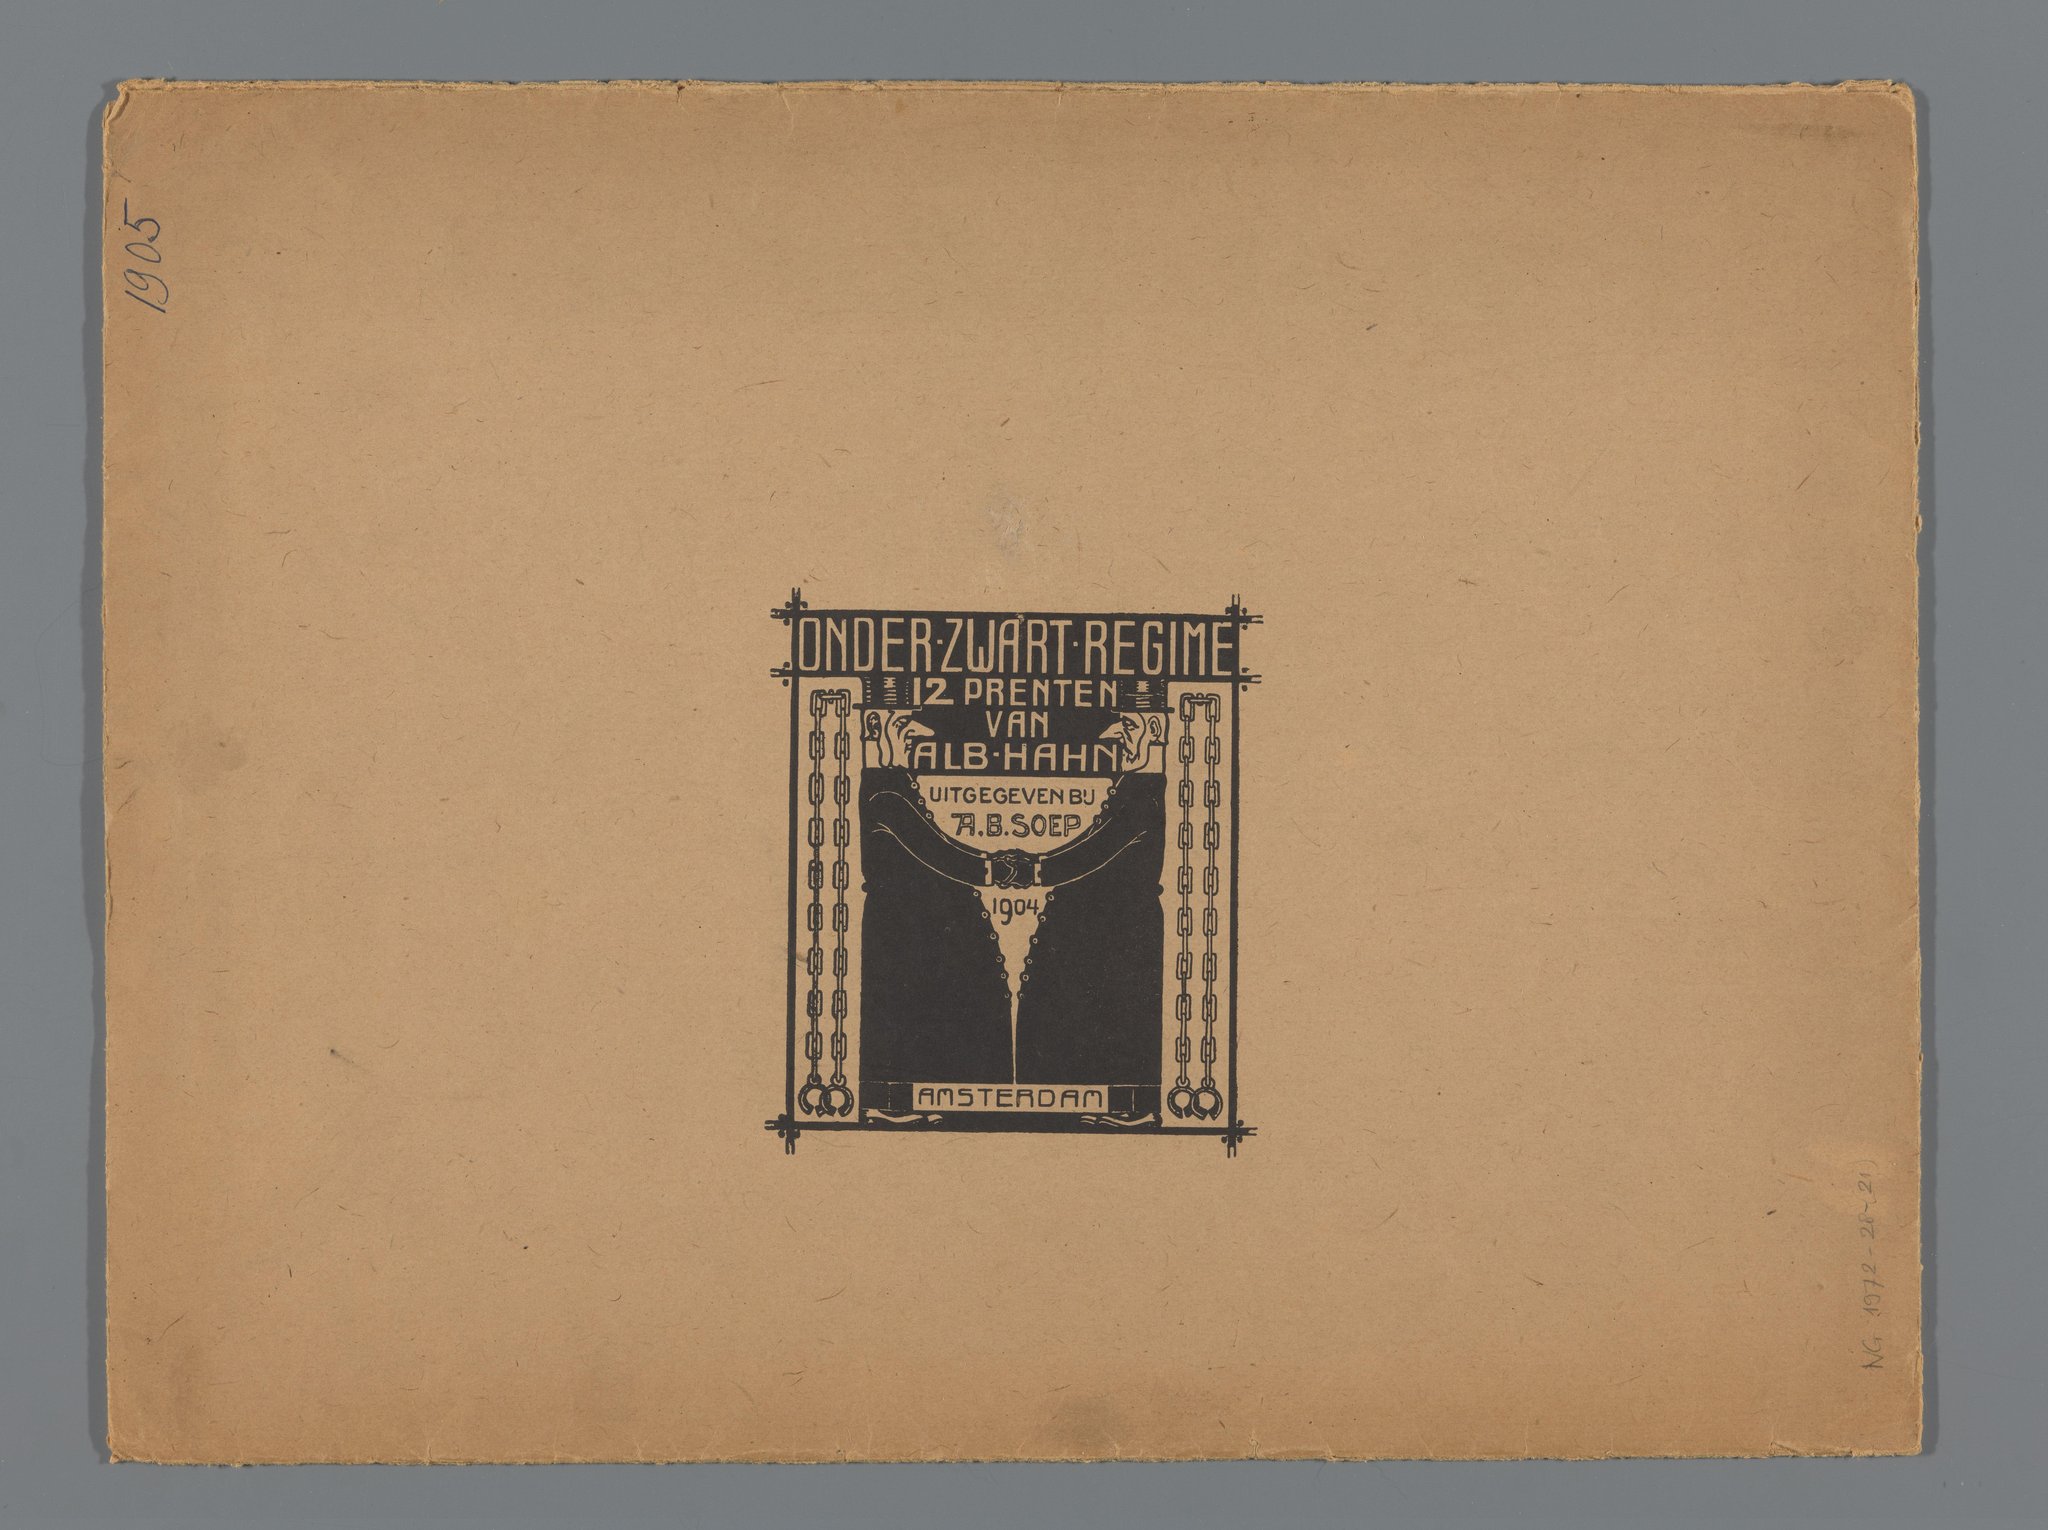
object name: folder container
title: Onder zwart regime / 12 prenten van Alb. Hahn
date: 1904-1905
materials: cardboard, paper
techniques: lithograph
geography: amsterdam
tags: the hague, abraham kuyper, political caricatures and satires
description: Bruin kartonnen map waarin een papieren binnenmap (1905) met titel bevattende twaalf genummerde prenten, gekleurd, met elk een vierregelig onderschrift. Op de voorkant een titelembleem (1904) met twee mannen in het zwart die elkaar de hand geven, met aan weerszijden kettingen en boeien. Achterste blad van de binnenmap bevat een gedrukte tekst over 'de zwarte wolk ... van de Regeering van Dr. Kuyper' en 'Het socialisme zal de verlossing brengen'.